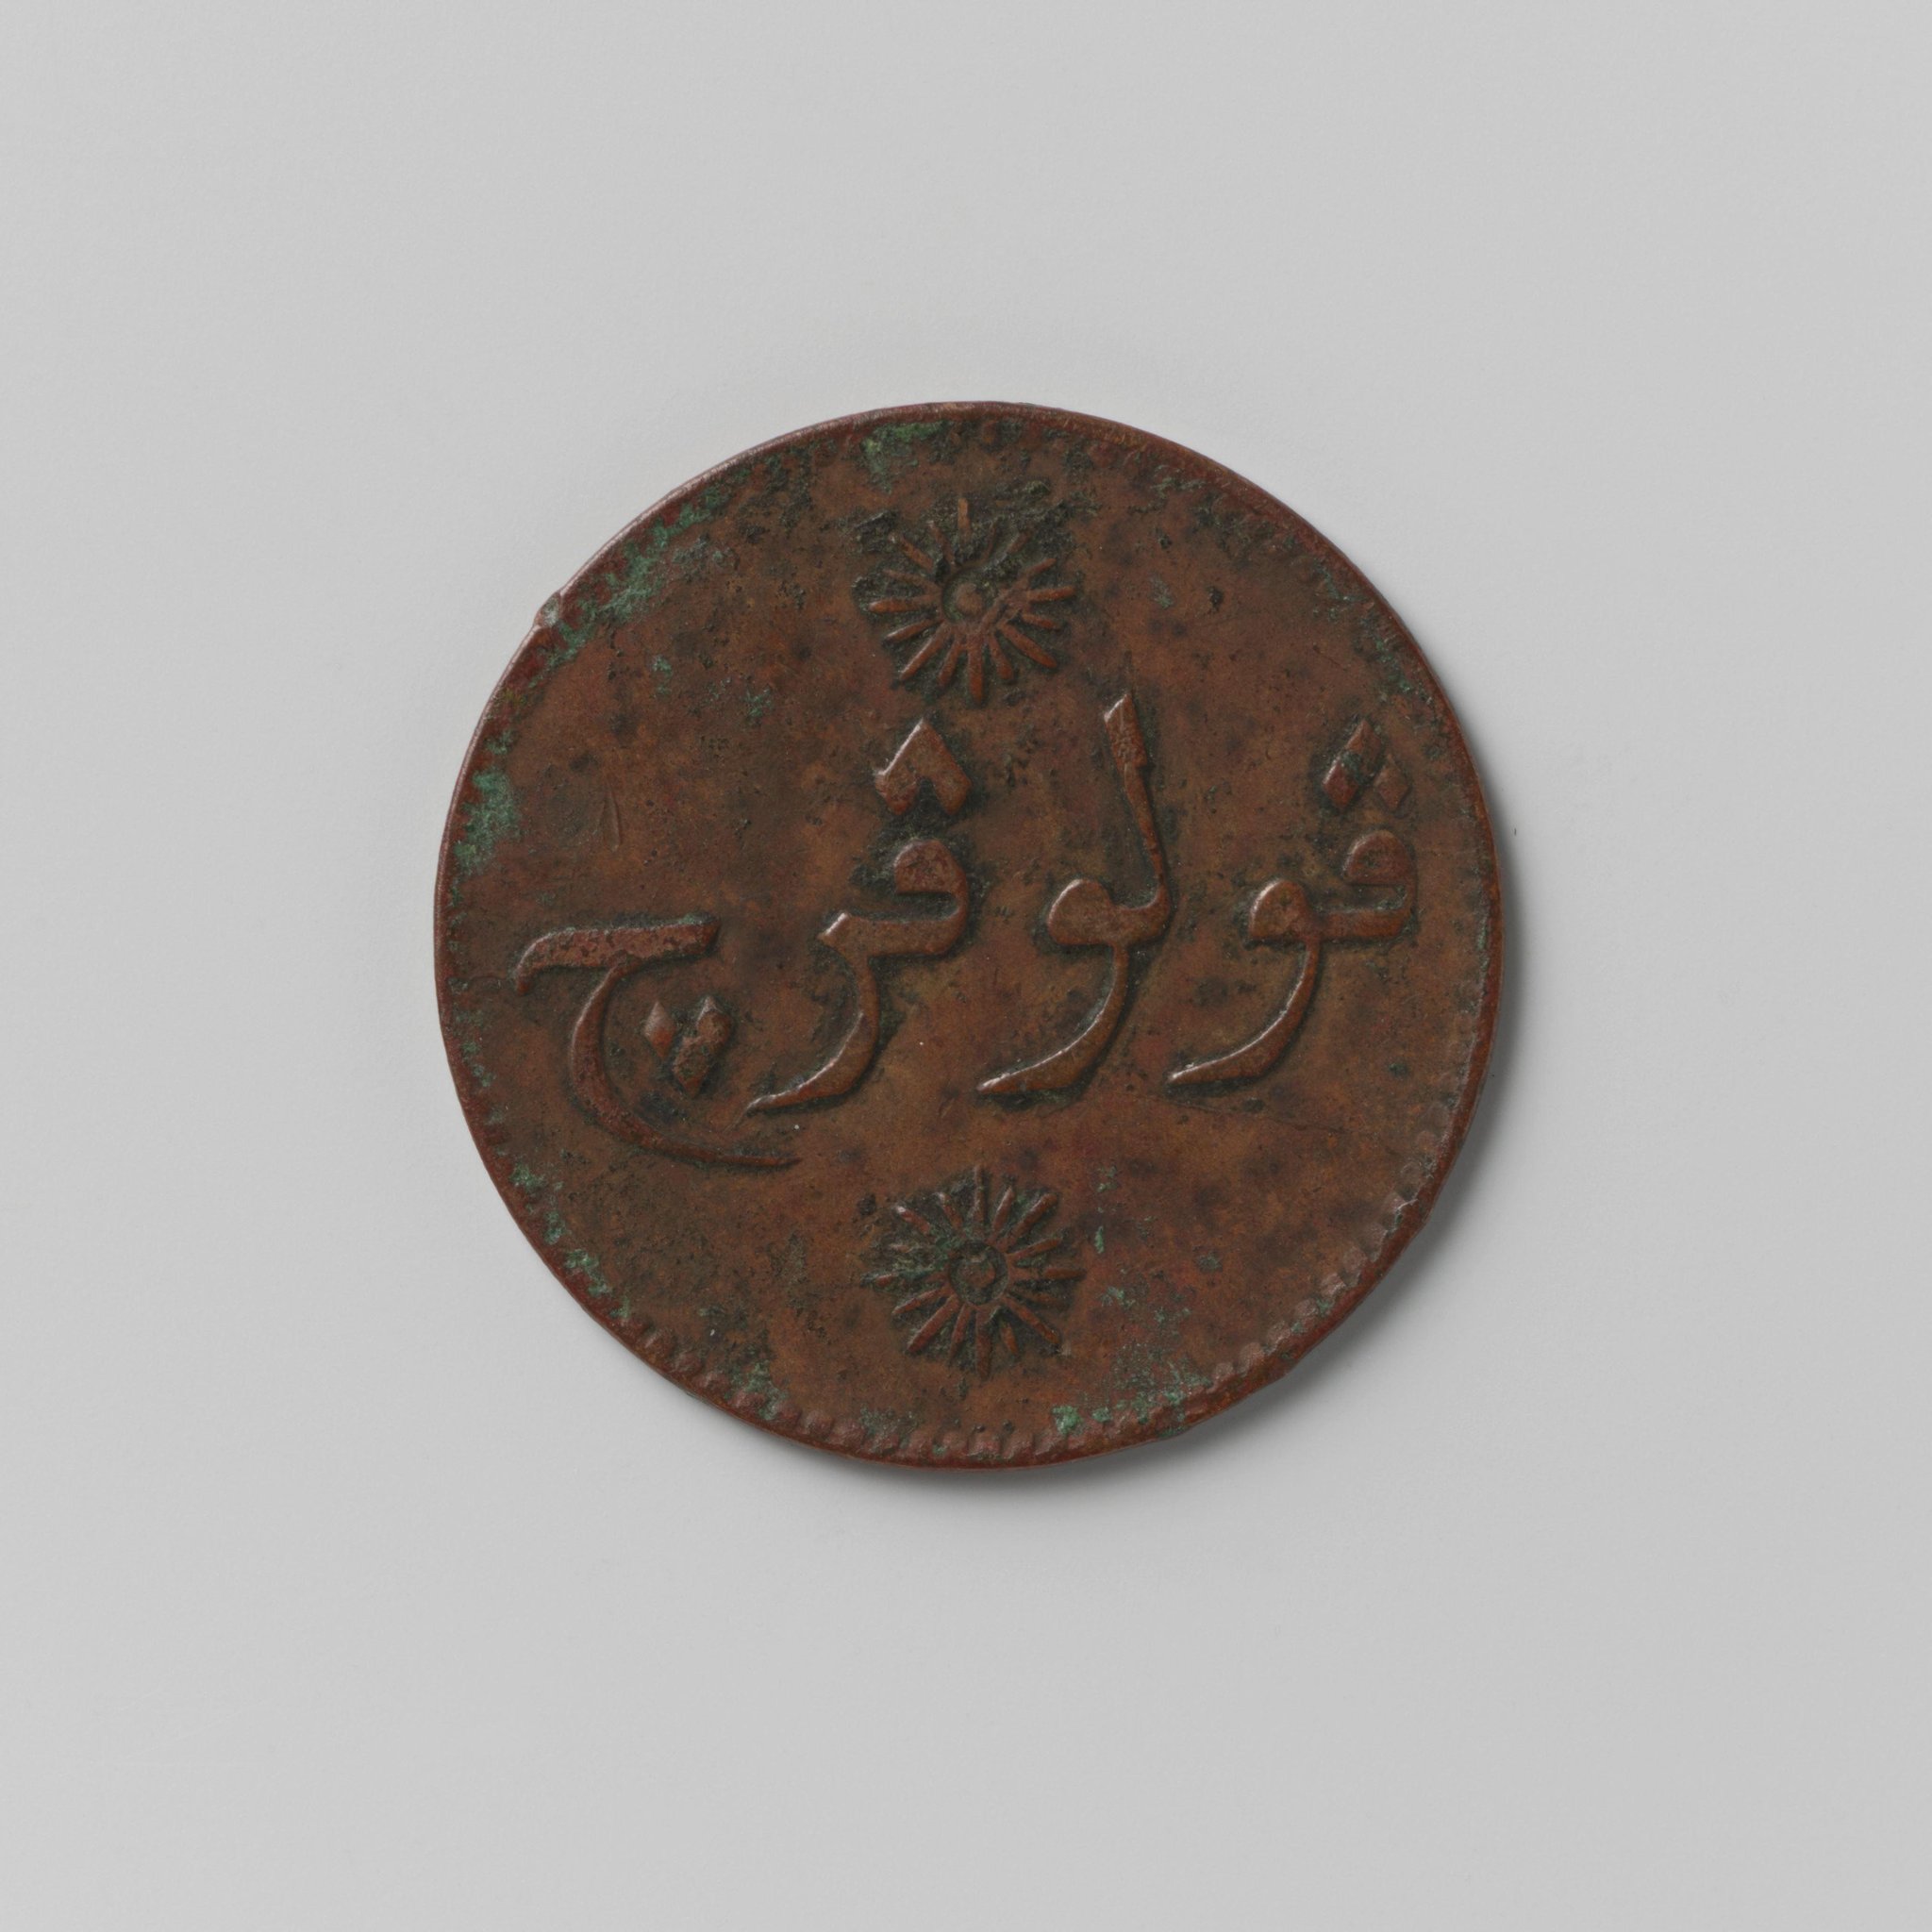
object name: coin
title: Kepeng voor Sumatra, 1835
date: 1835-1836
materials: copper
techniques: striking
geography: birmingham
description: Koperen munt. Particuliere munt. Voorzijde: eenregelig opschrift: aanduiding in het Maleis in Arabische lettertekens: Poeloe Percha=Sumatra, waarboven en waaronder zon. Keerzijde: eenregelig Maleis opschrift in Arabische lettertekens: een kepeng, waarboven waarde-aanduiding 1 en waaronder het jaartal 1251 in Islamitische tijdsrekening. Gladde rand.